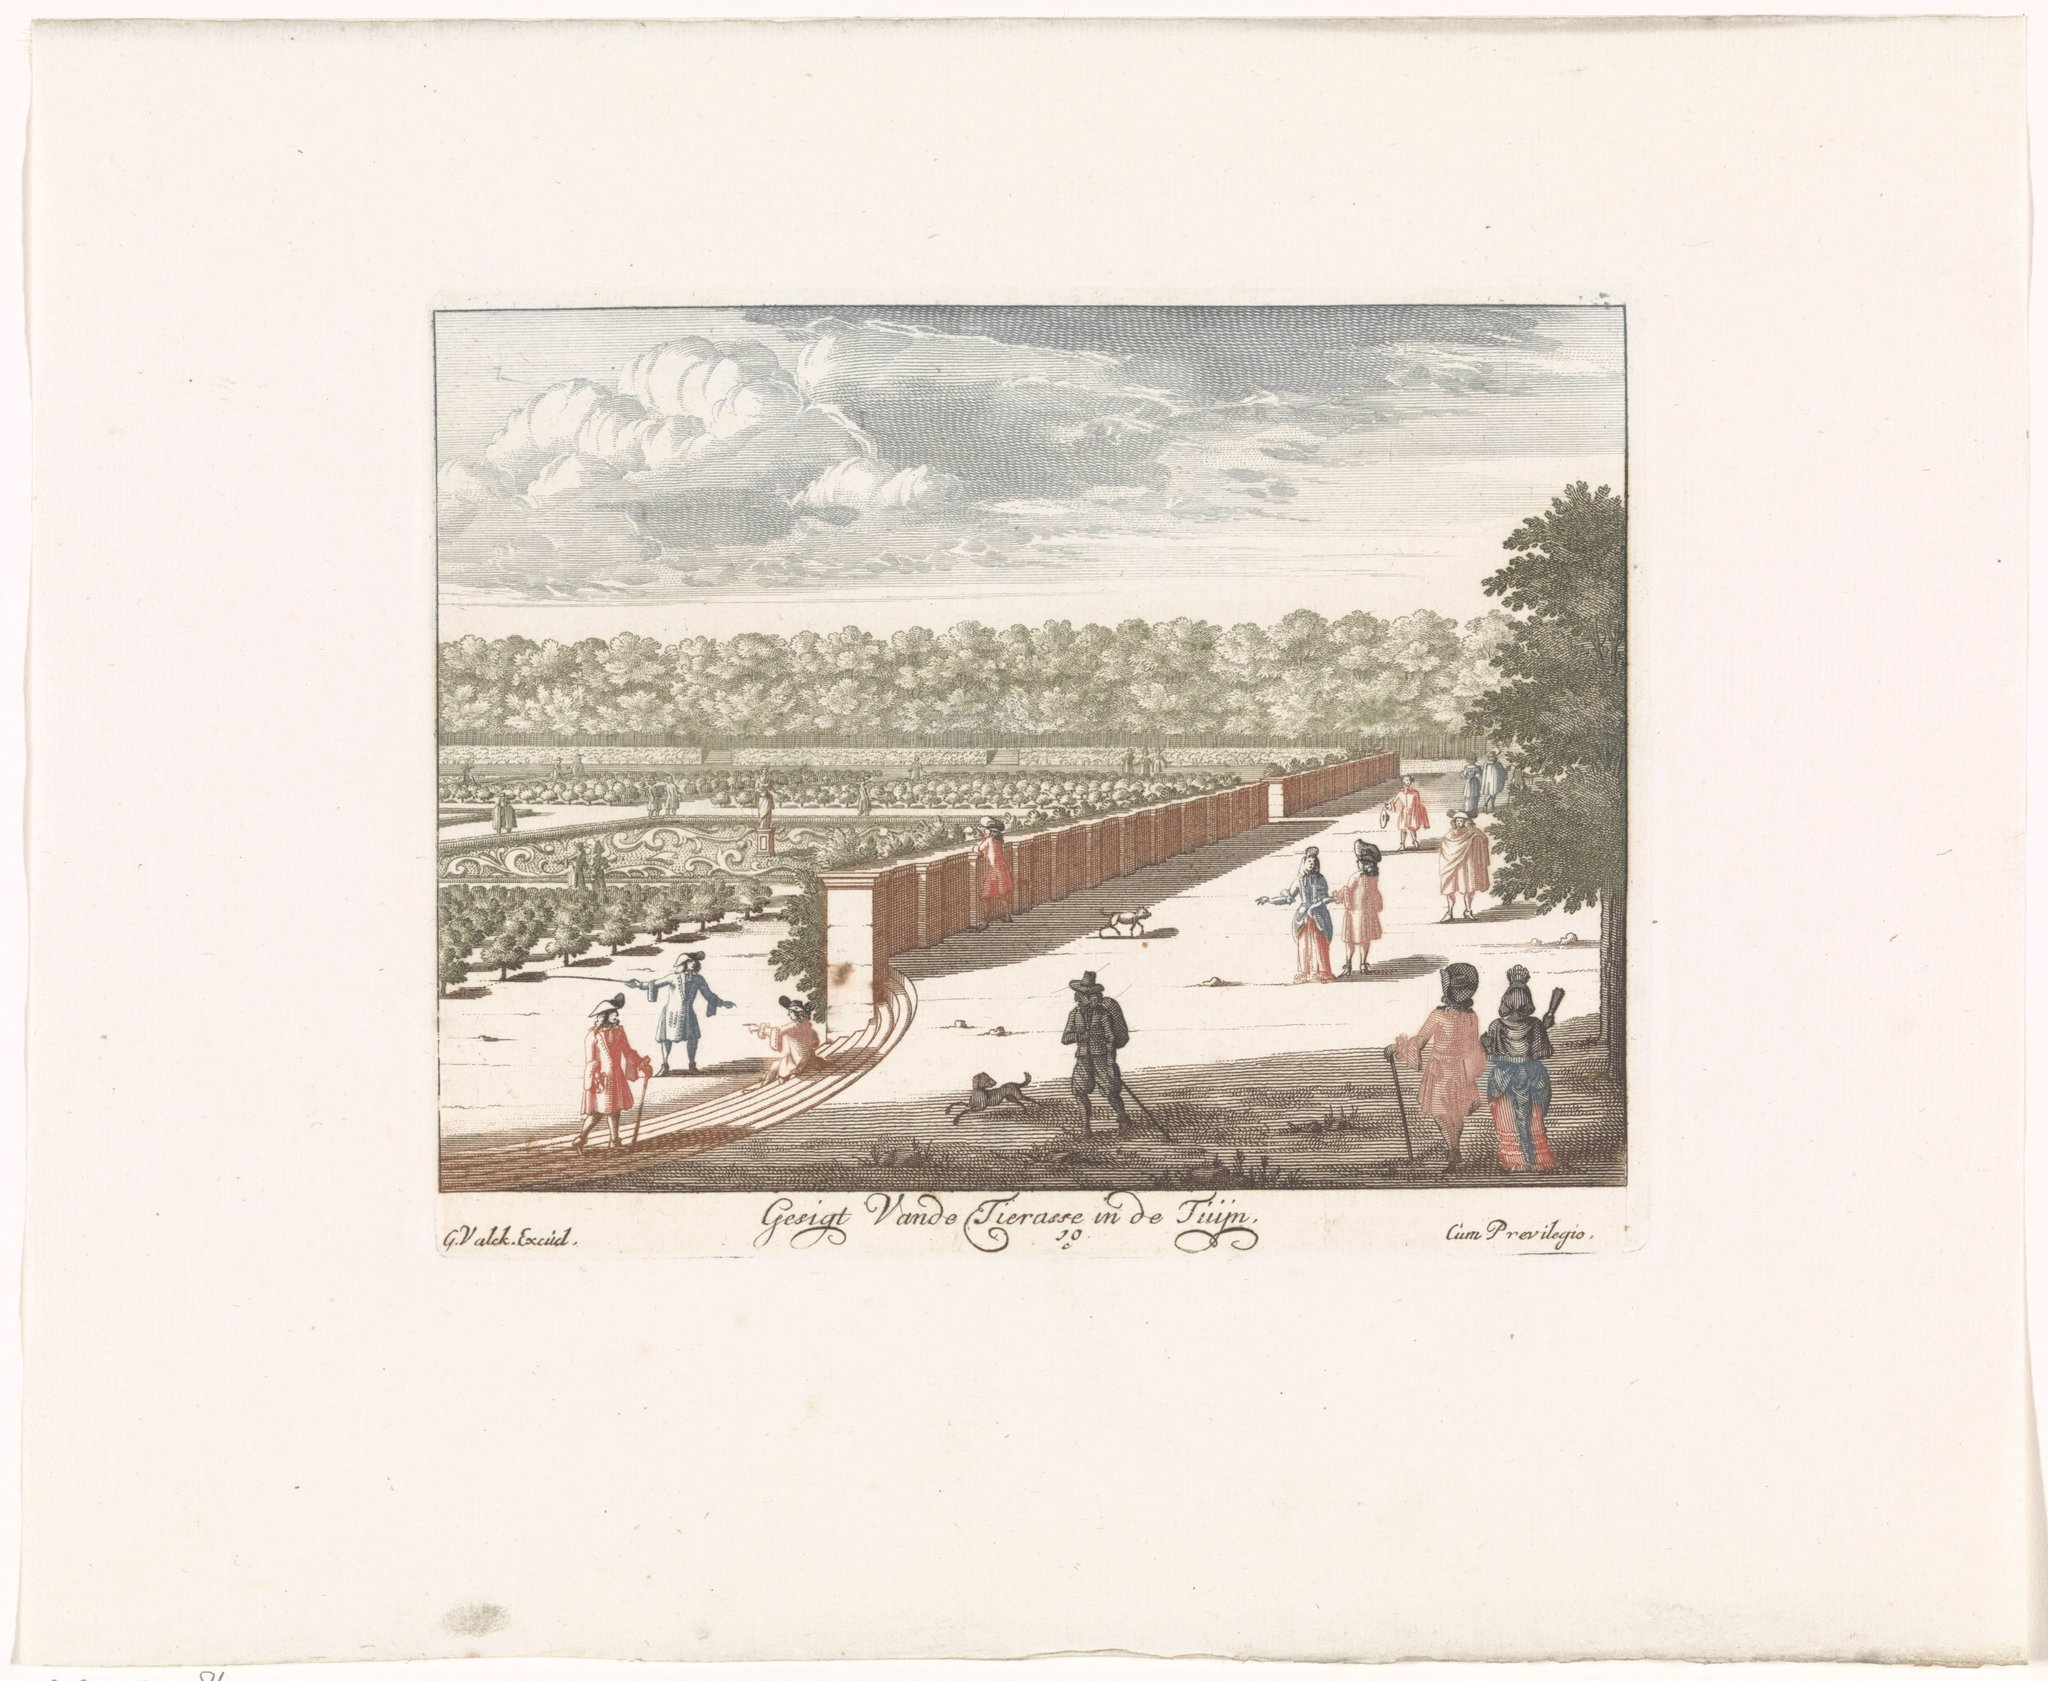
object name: print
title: Veues et perspectives de Soesdyck, chasteau & maison de plaisance du roy de la Grande Bretagne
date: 1695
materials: paper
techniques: etching, lithography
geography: amsterdam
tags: the hague, william iii (prince of orange and king of england, scotland, and ireland), lay-out of garden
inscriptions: collector's mark: Lugt 2228, collector's mark: Lugt 2760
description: Gezicht vanaf het terras op de tuin van Paleis Soestdijk, jachtslot van stadhouder Willem III van Oranje-Nassau. Op het terras wandelen figuren en lopen honden.